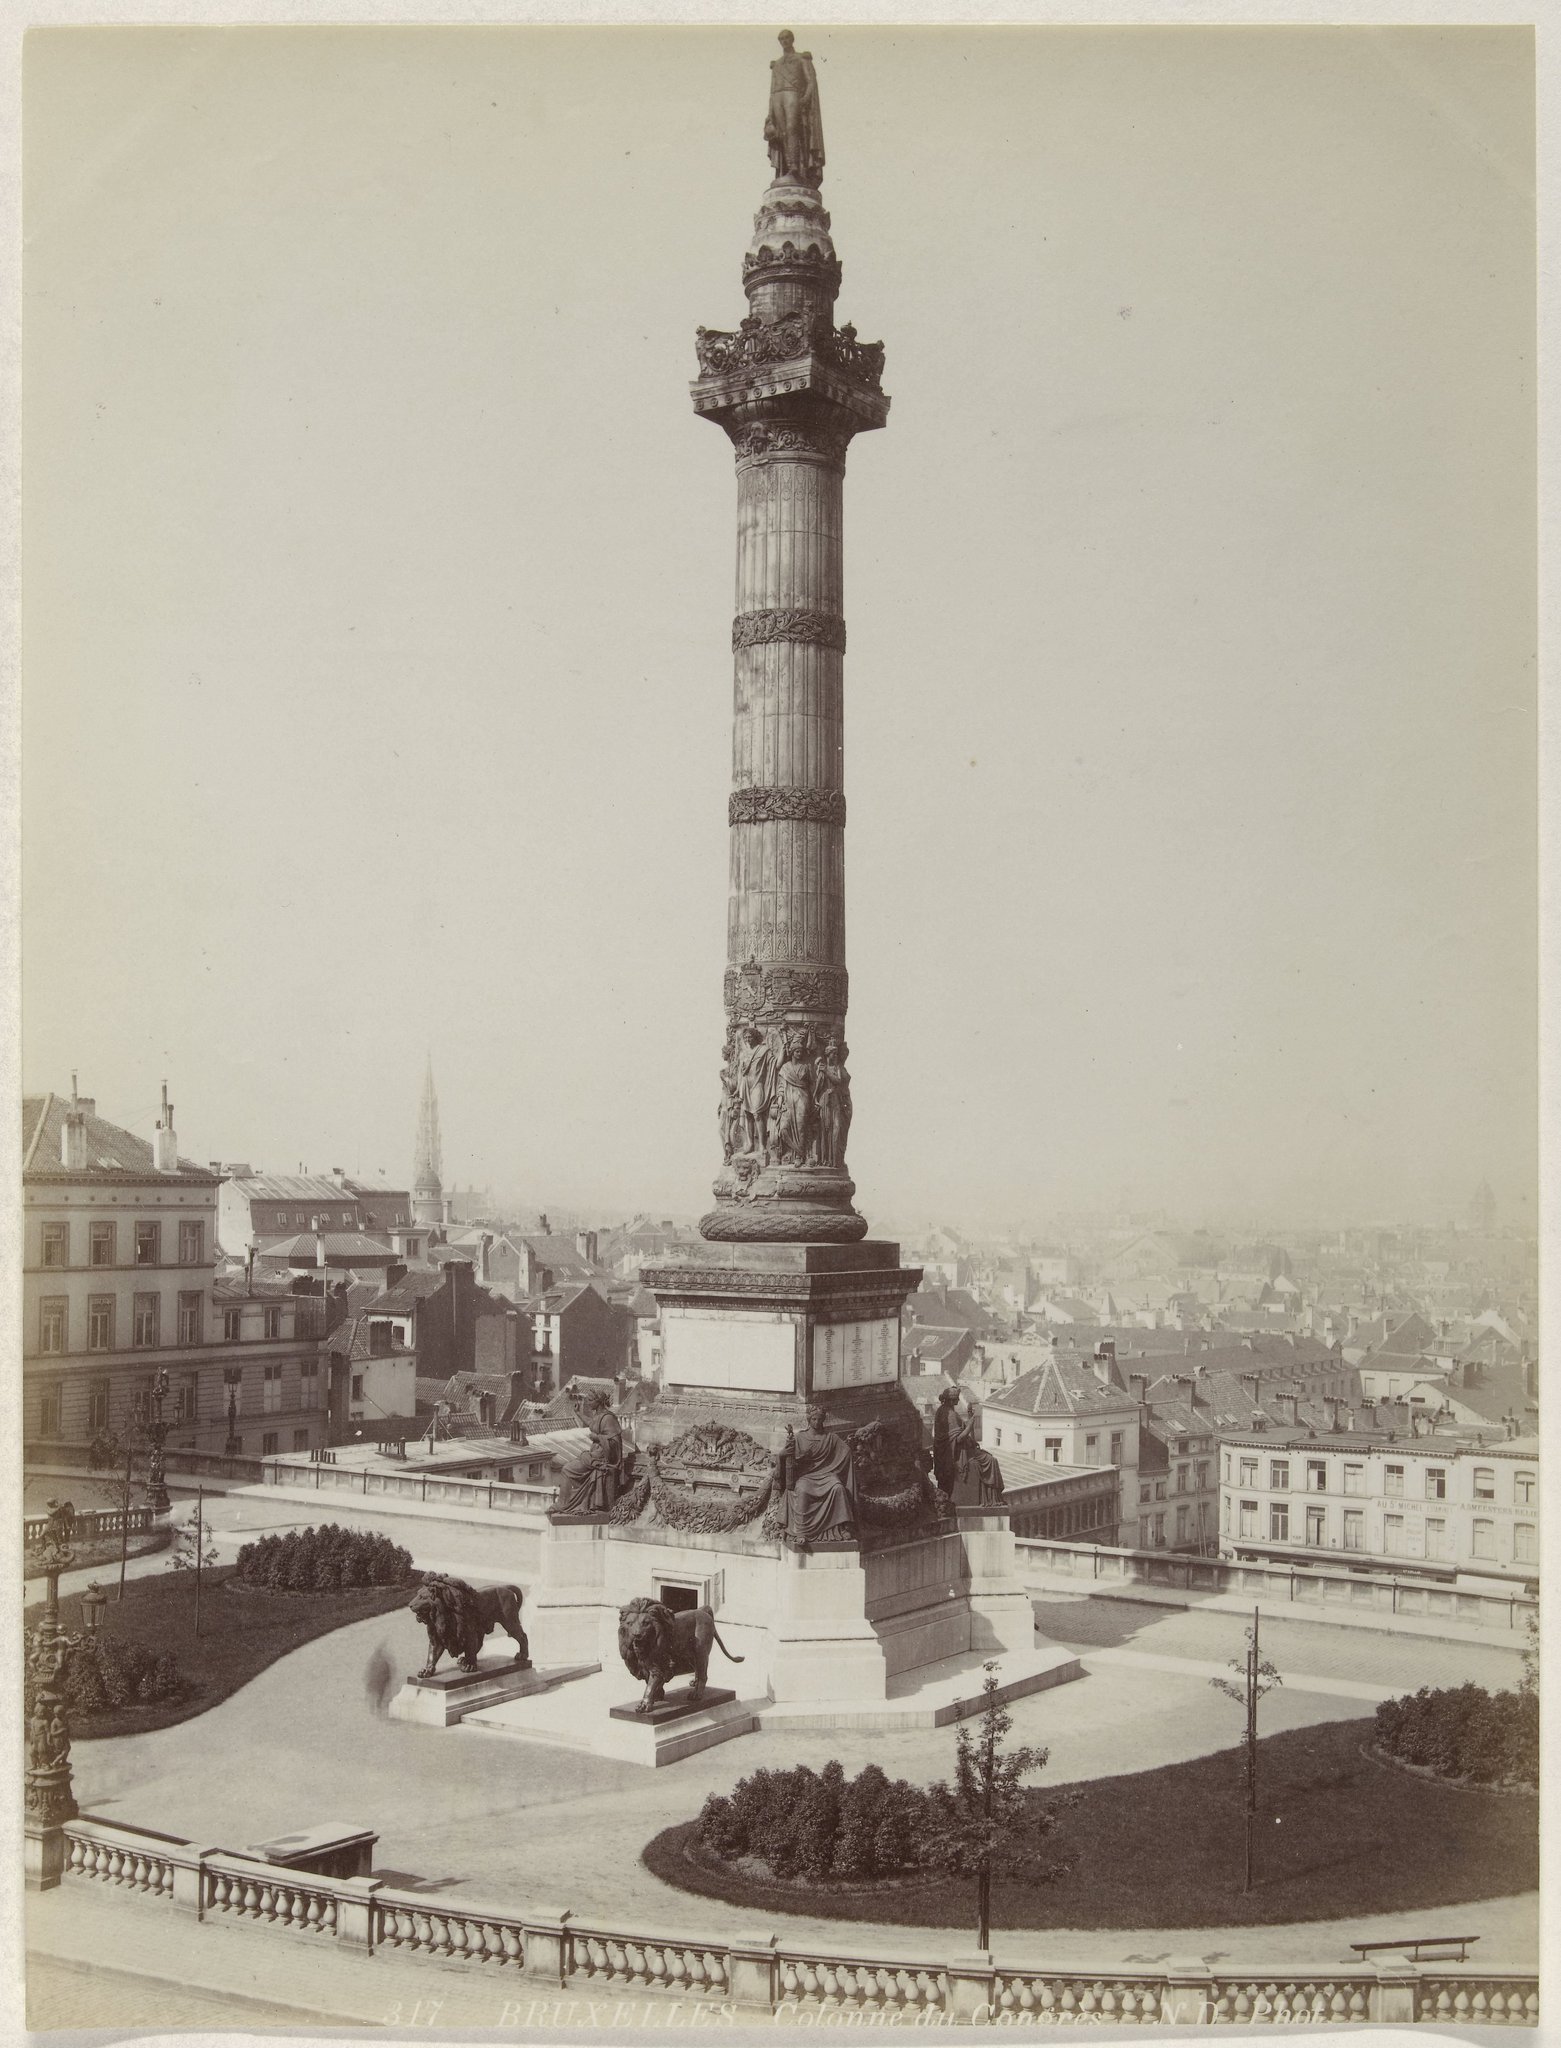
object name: photograph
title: Bruxelles - Colonne du Congres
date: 1863-1900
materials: paper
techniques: albumen print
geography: brussels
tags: monument, statue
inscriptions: number: ‘16’, inscription: ‘317 Bruxelles - Colonne du Congres N.D. phot’